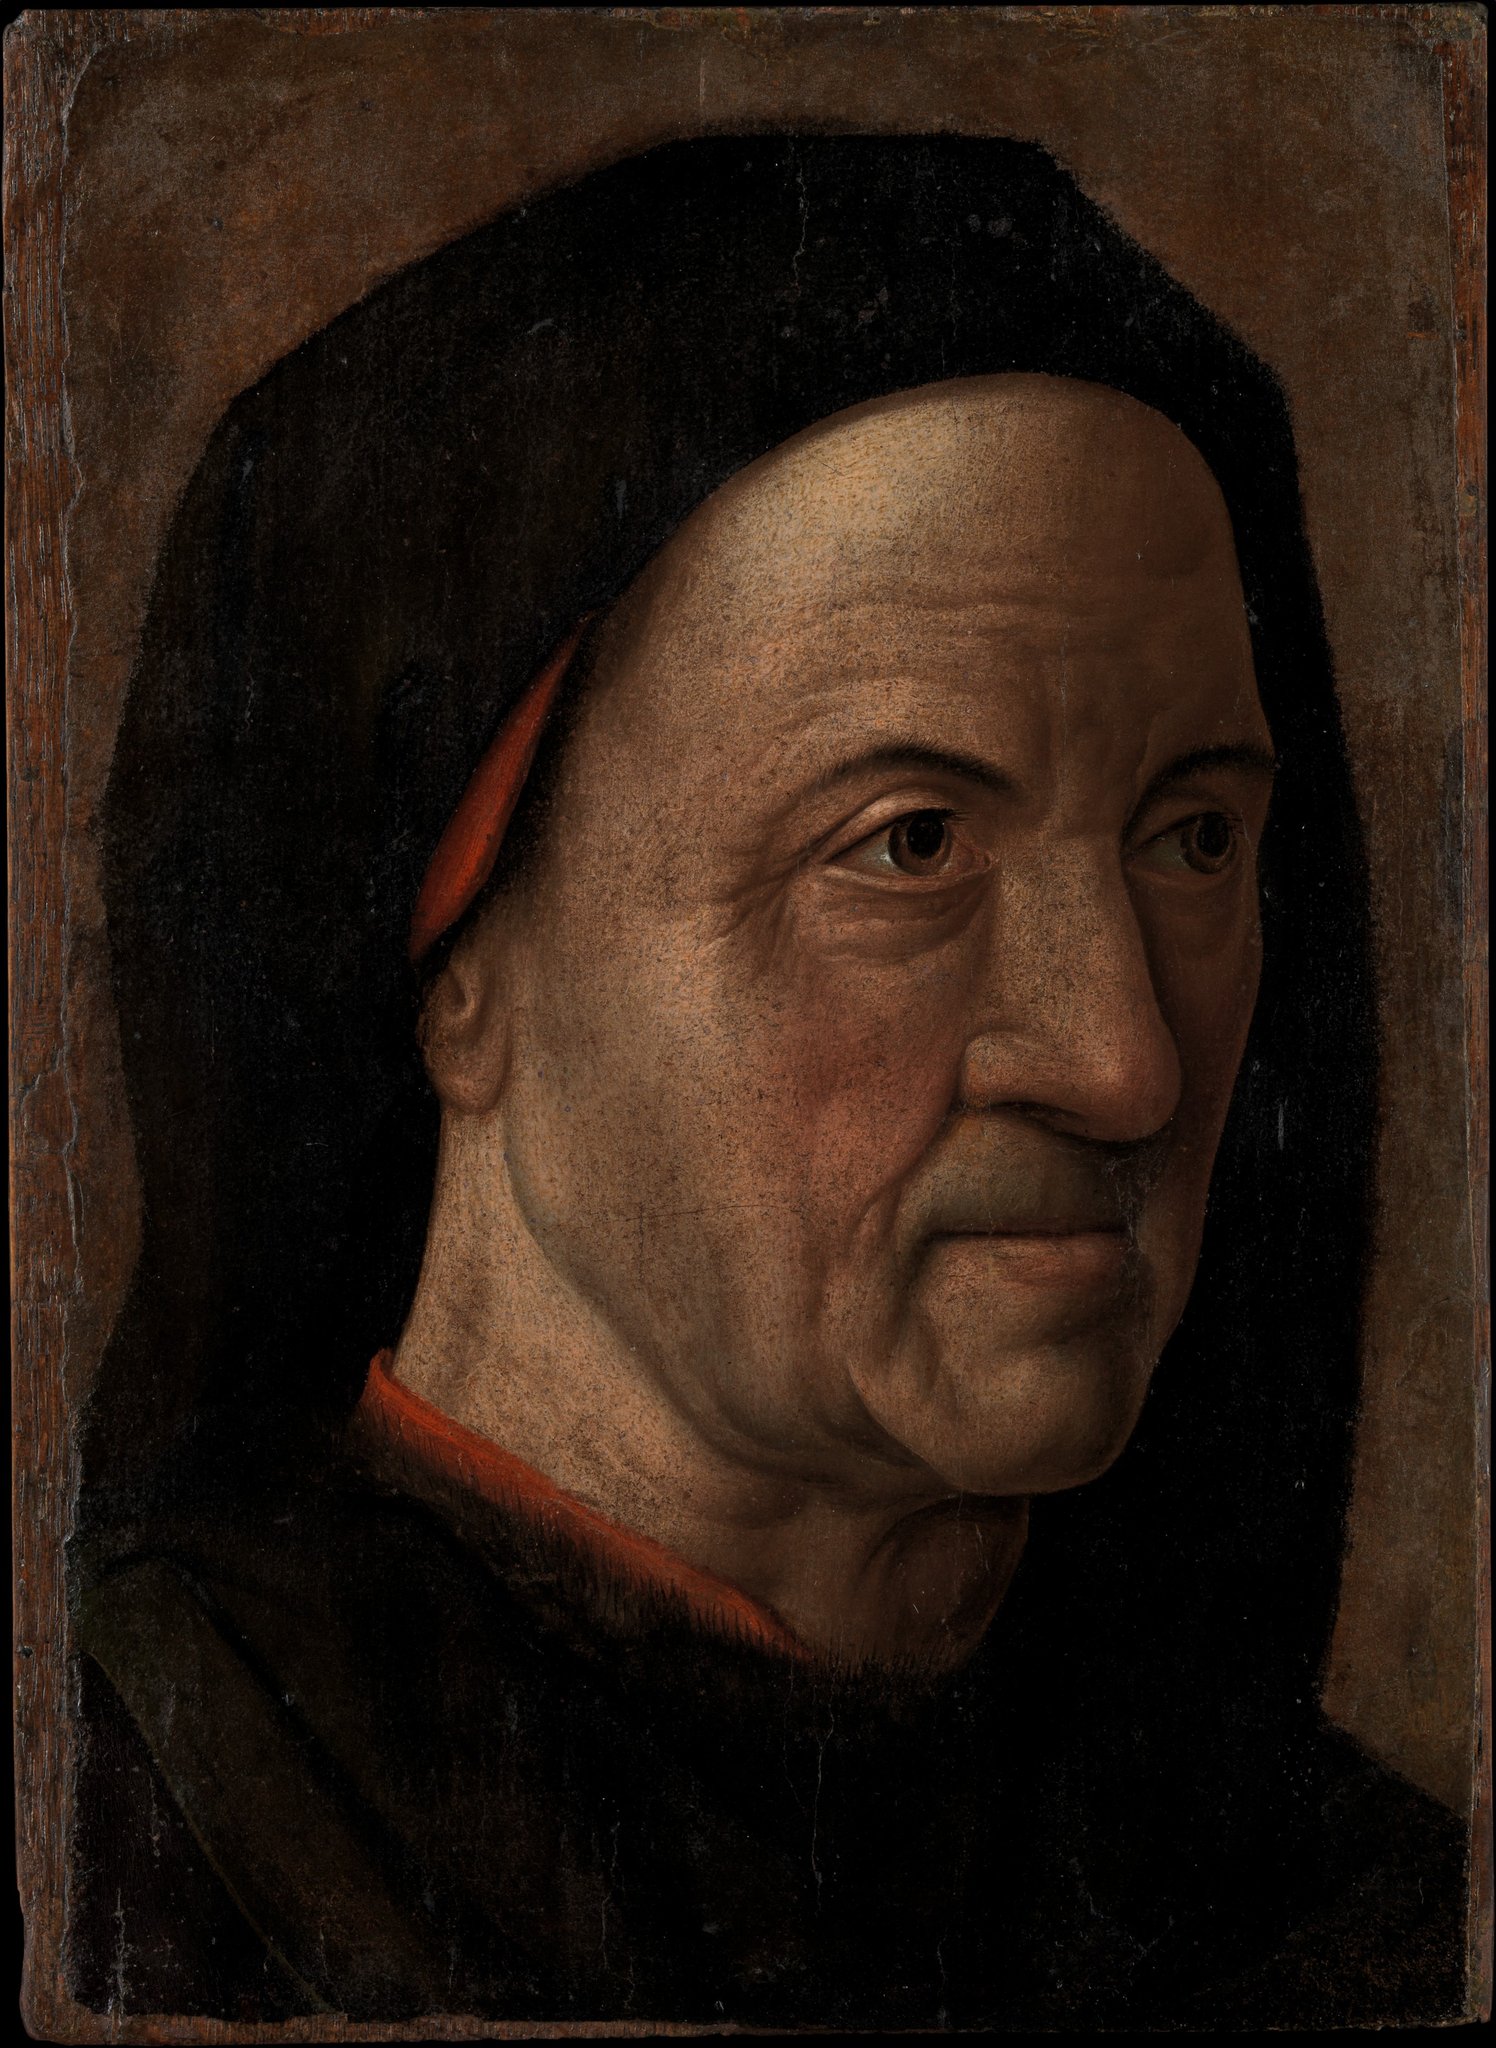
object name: painting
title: Portrait of an Old Man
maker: hugo van der goes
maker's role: artist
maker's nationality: netherlandish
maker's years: 1467-1482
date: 1470-1475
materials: oil, paper, wood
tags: men,portraits